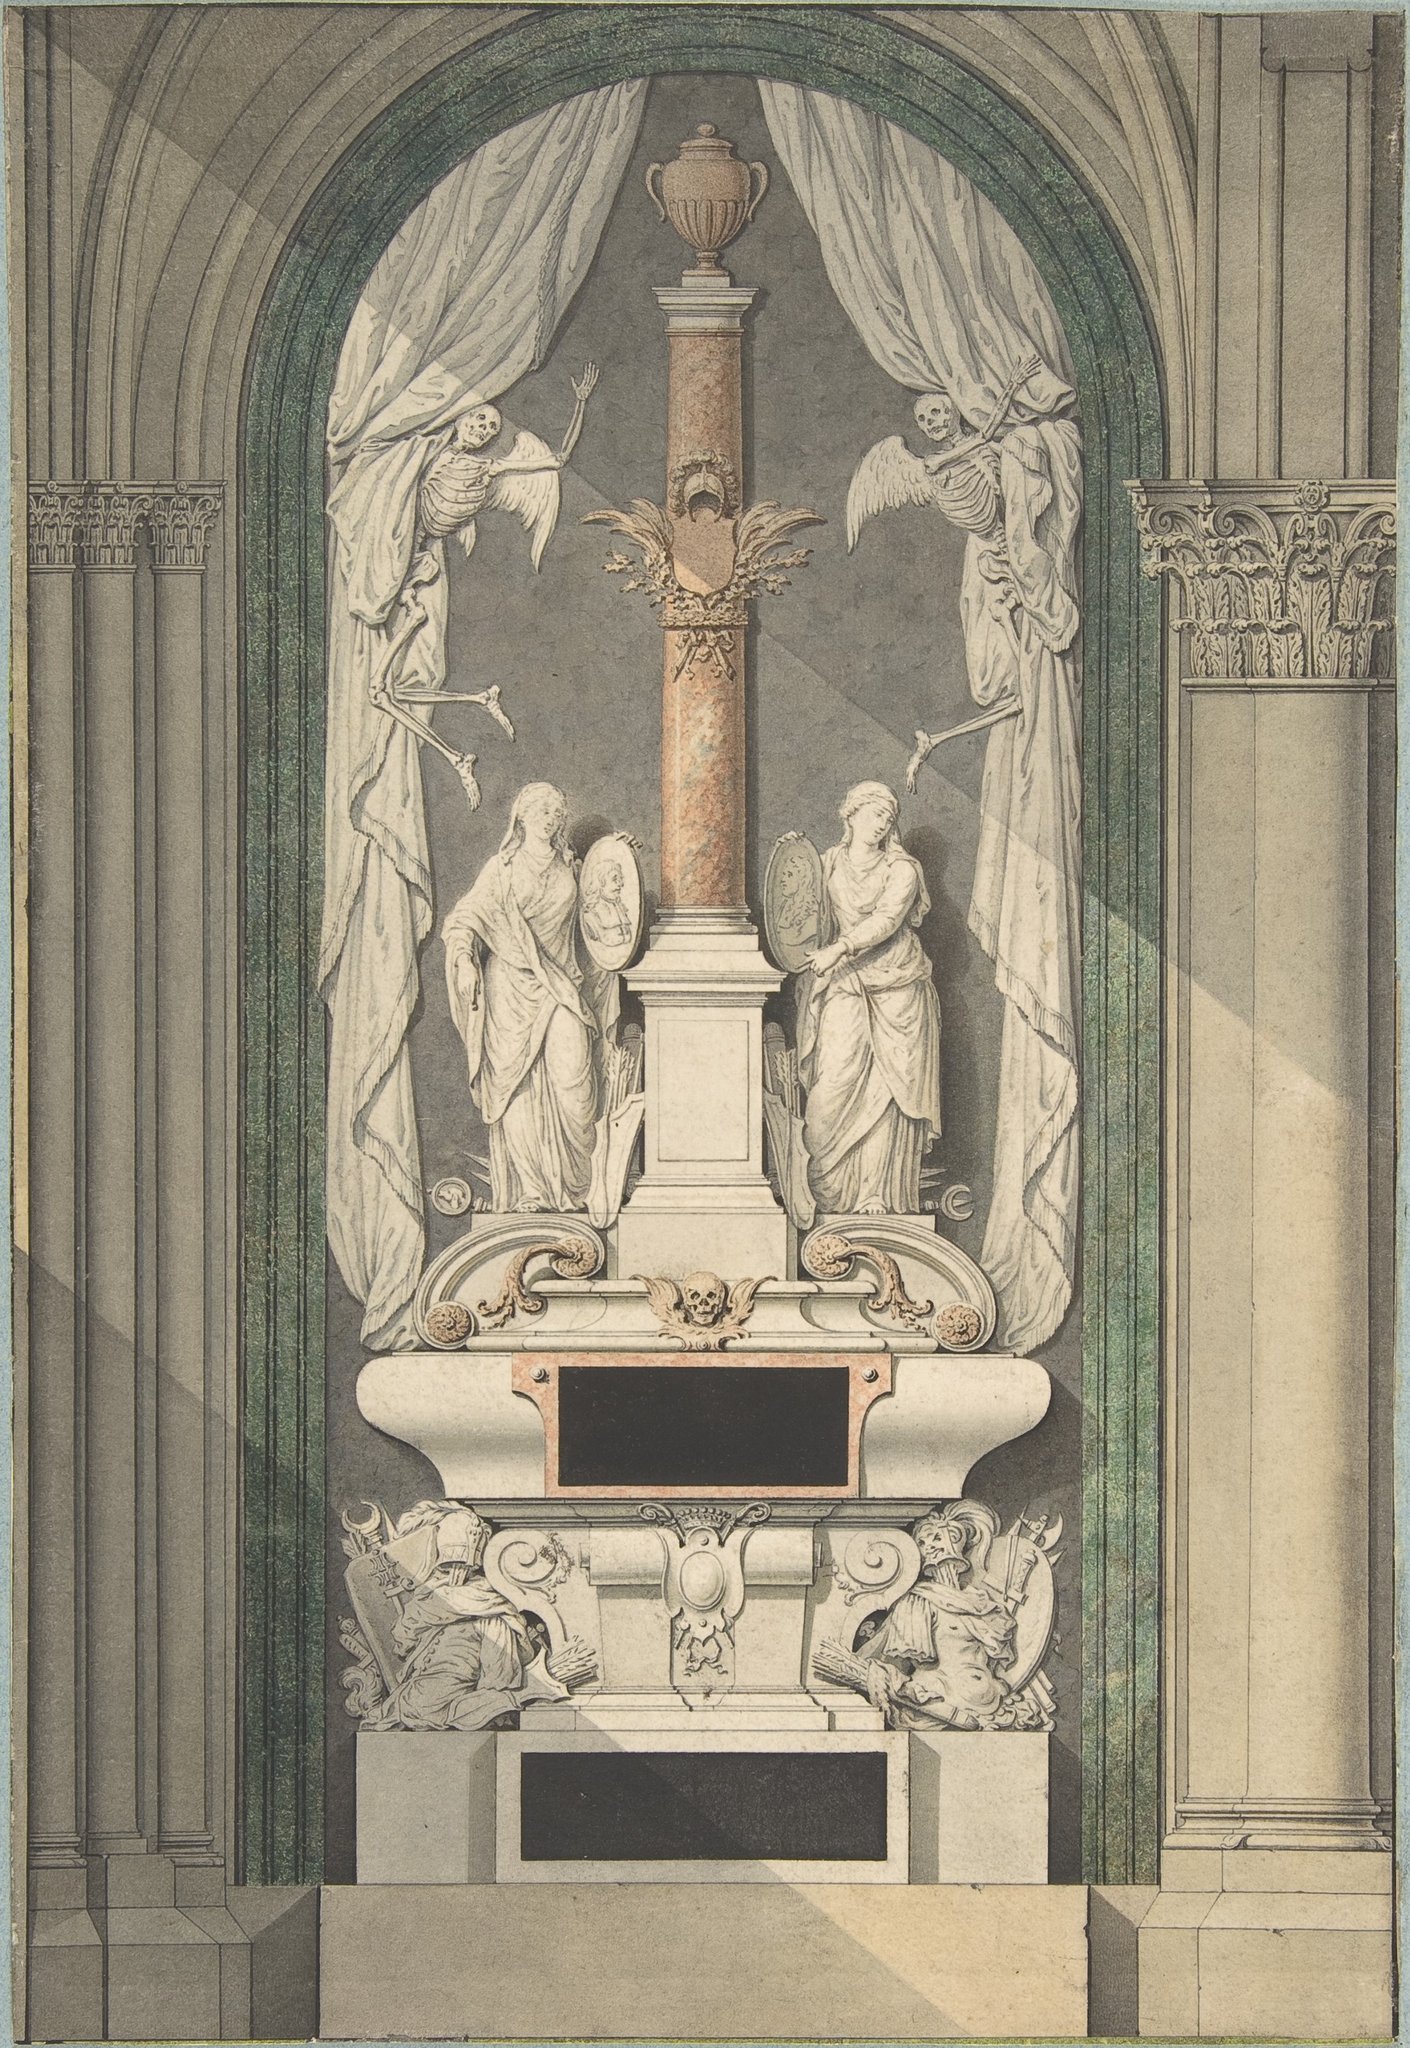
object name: drawing collection ornament architecture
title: The Castellan Tomb in Saint Germain-des-Prés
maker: jean chafourier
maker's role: artist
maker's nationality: french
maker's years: 1679-1757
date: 1724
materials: ink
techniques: brush, pen, wash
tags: tombs,skulls,profiles,women